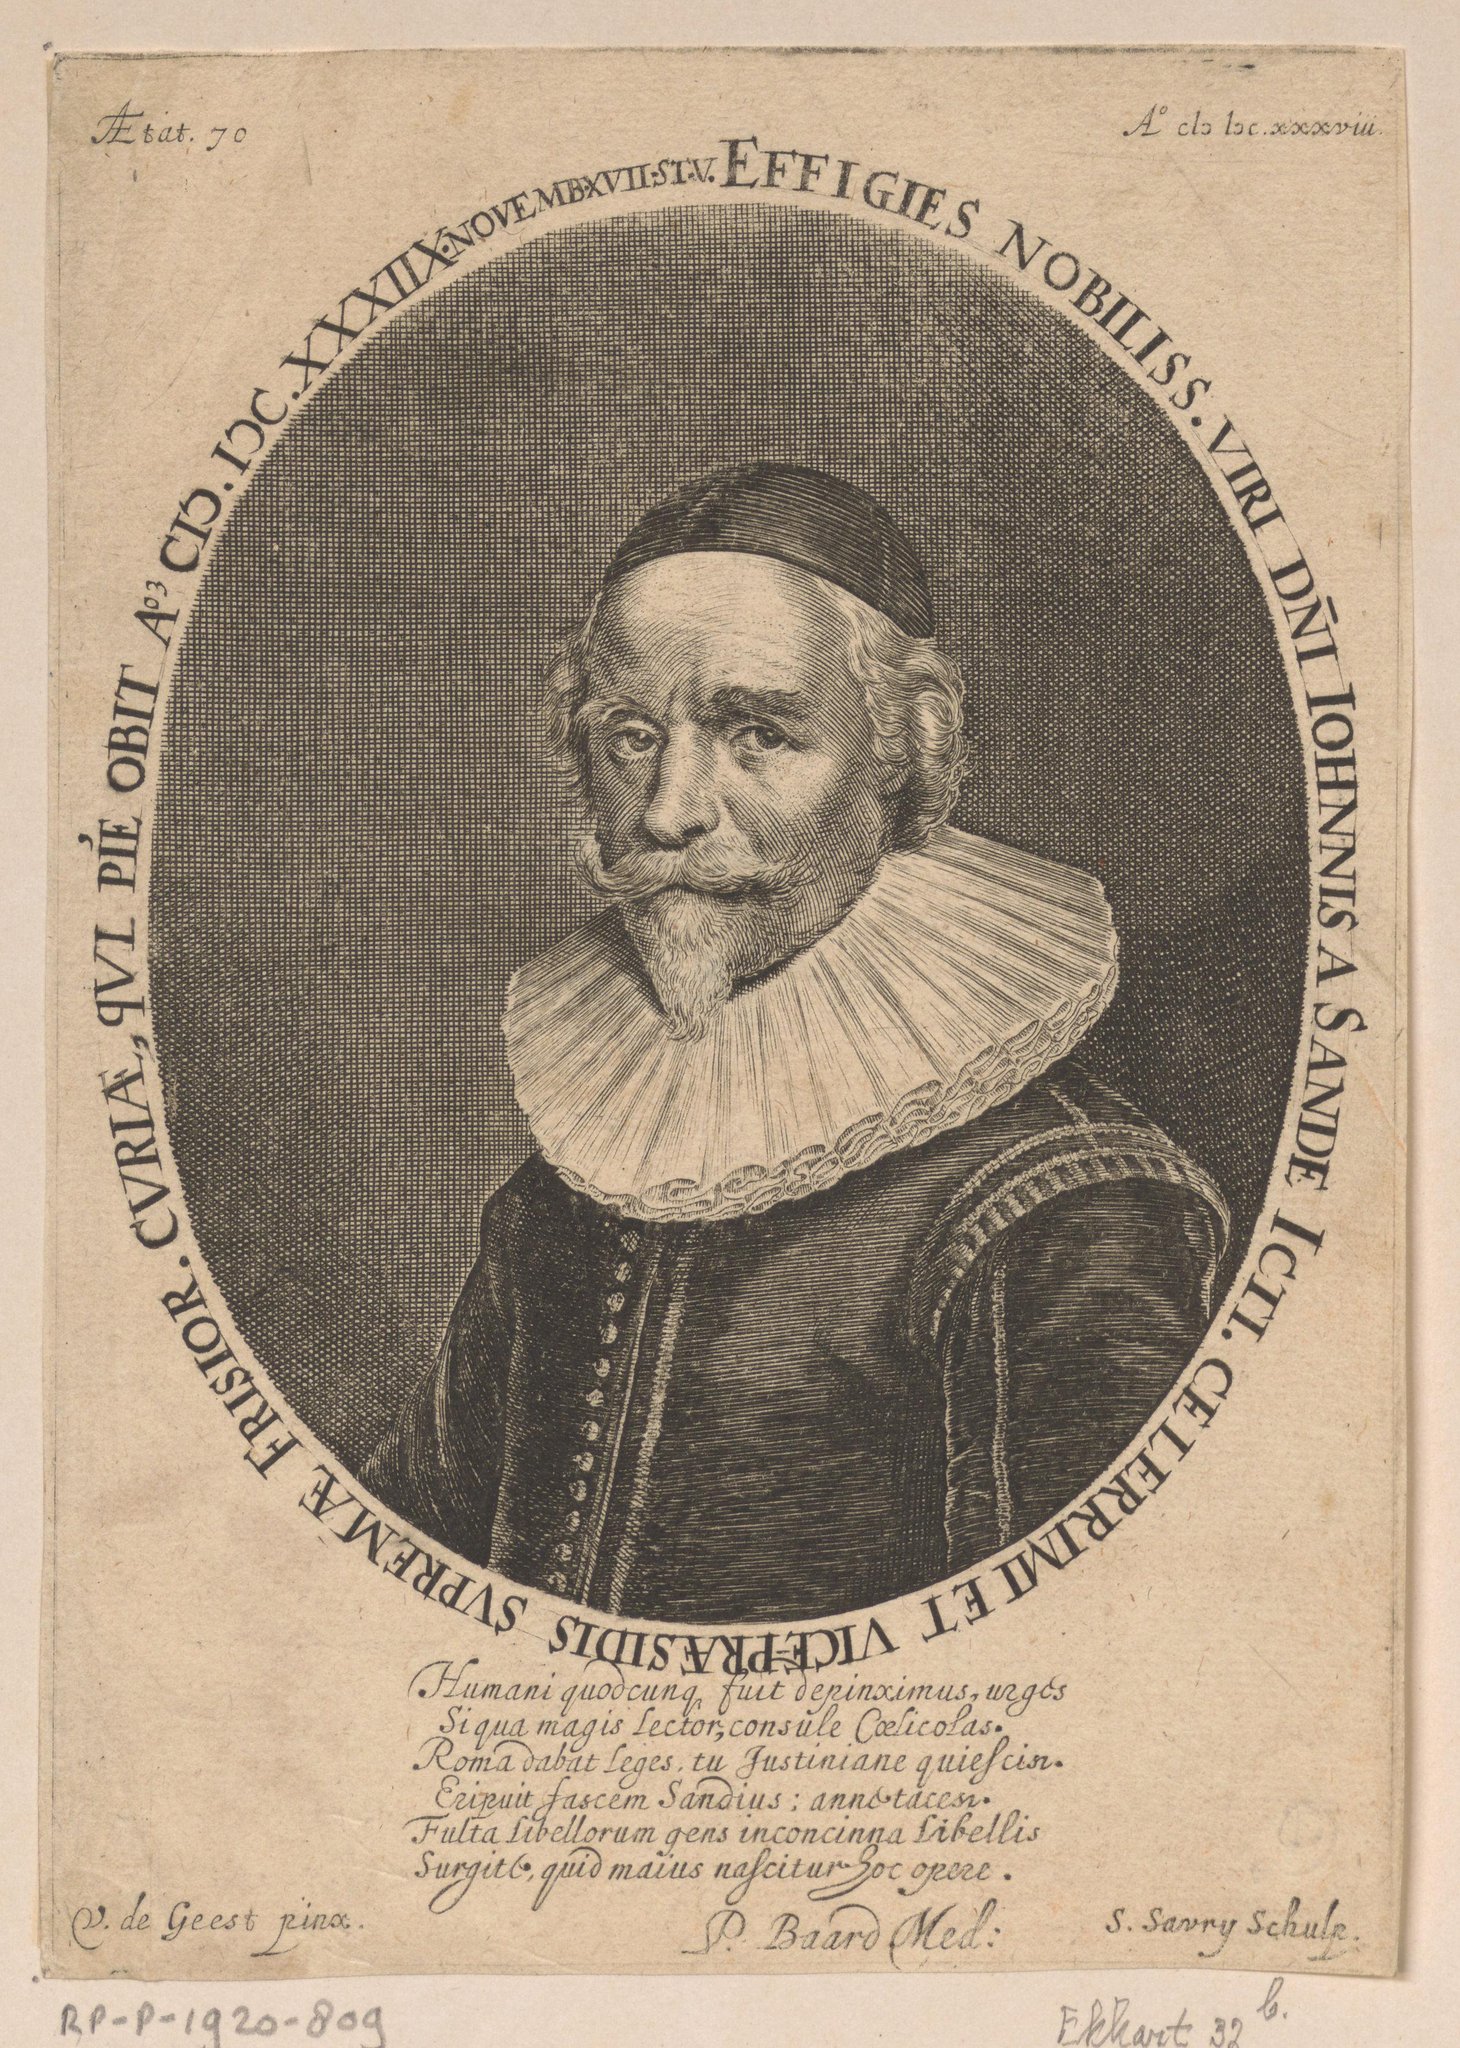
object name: print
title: Portret van Johan van den Sande op 70-jarige leeftijd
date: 1652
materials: paper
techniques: engraving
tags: arnhem, johan van den sande, historical persons, portrait of a writer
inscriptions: inscription: ‘D’, collector's mark: Lugt 2228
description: Prent met tekst op verso gebruikt in: Sande, Johan van der. Vijf boecken der gewysder saecken voor den hove van Vries-land (...). Leeuwarden: s.n., 1652.